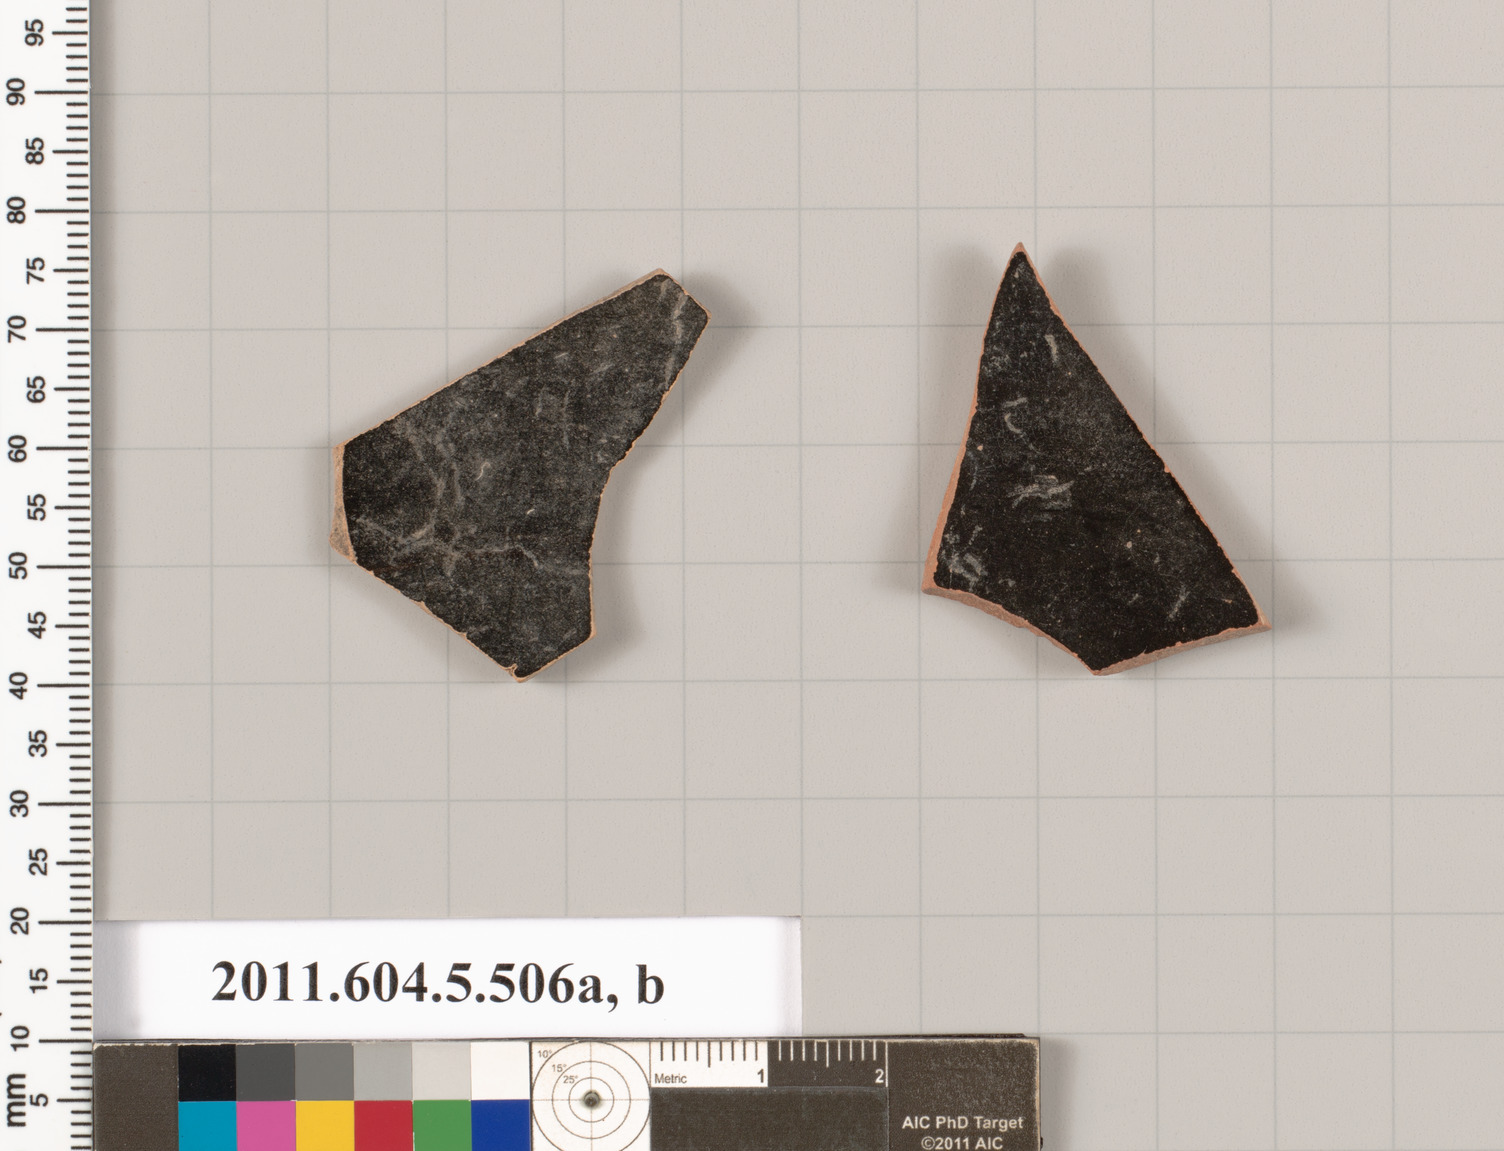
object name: kylix fragment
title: Terracotta fragments of kylikes (drinking cups)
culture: greek, attic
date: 600-401 BCE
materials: terracotta